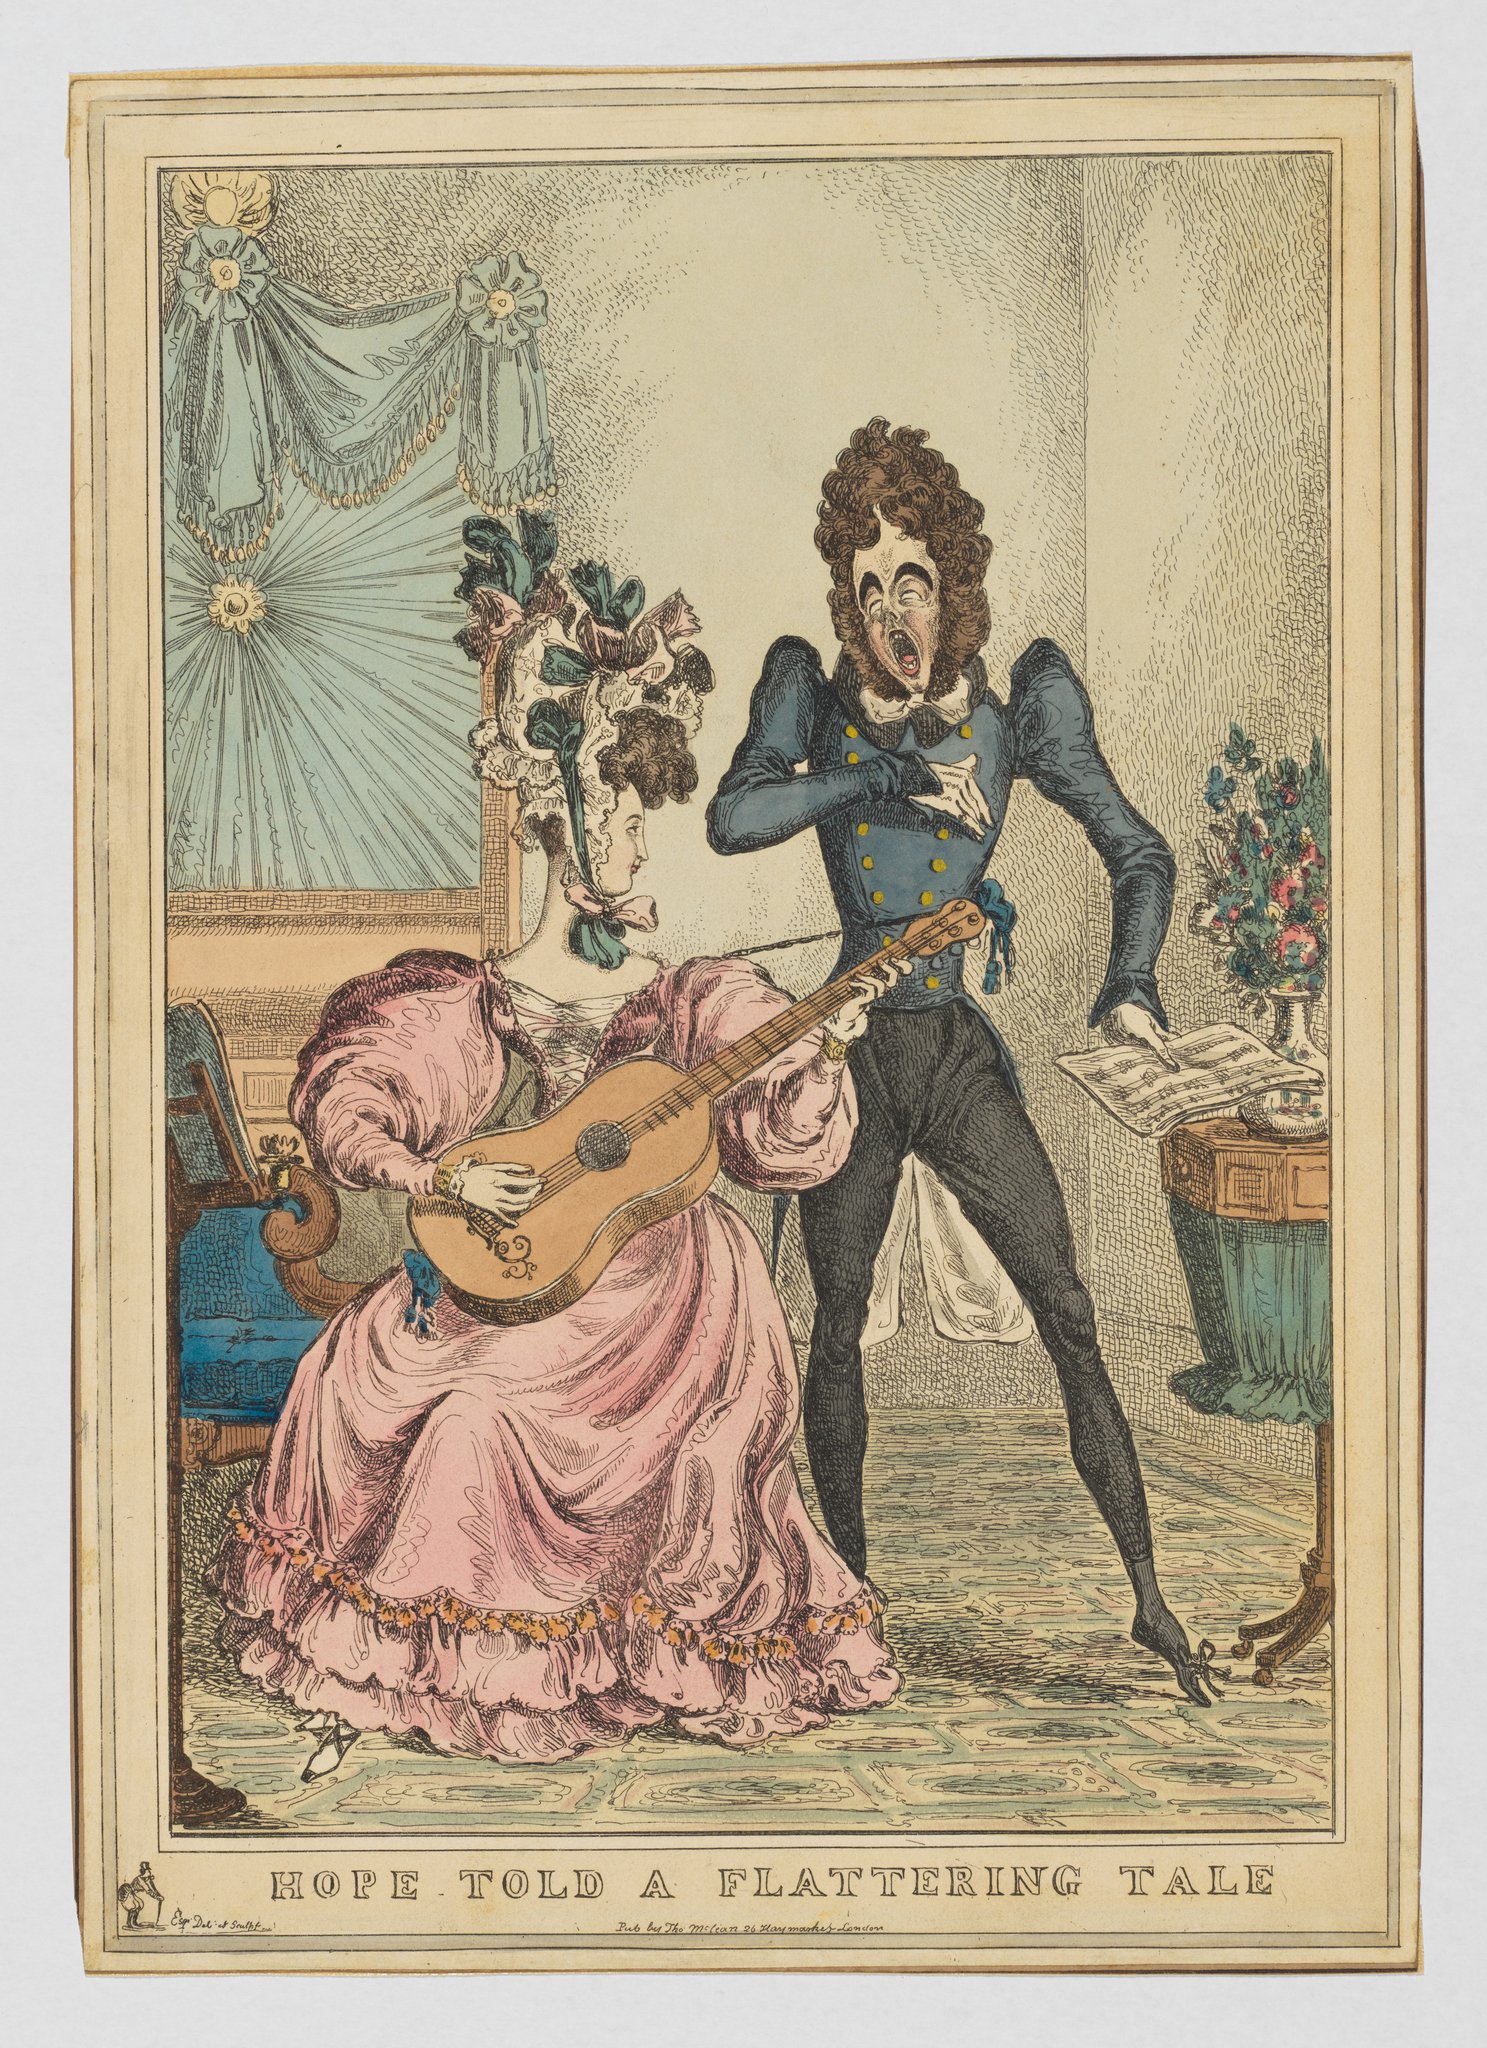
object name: print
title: Hope Told a Flattering Tale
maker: william heath ('paul pry')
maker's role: artist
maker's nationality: british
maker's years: 1794-1840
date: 1828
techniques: etching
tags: satire,men,women,guitars